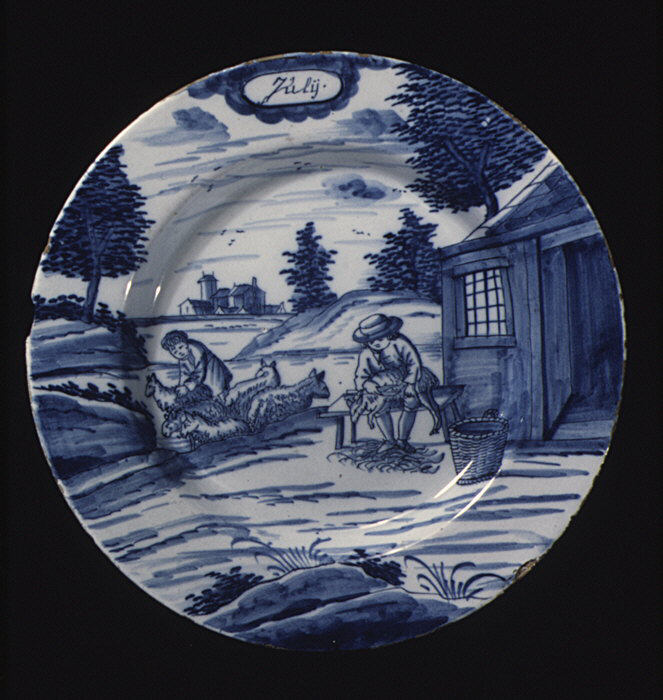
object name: plate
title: Plate (part of a set)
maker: de porceleyne bijl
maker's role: maker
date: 1764-1788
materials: earthenware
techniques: glazing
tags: houses,men,sheep,trees